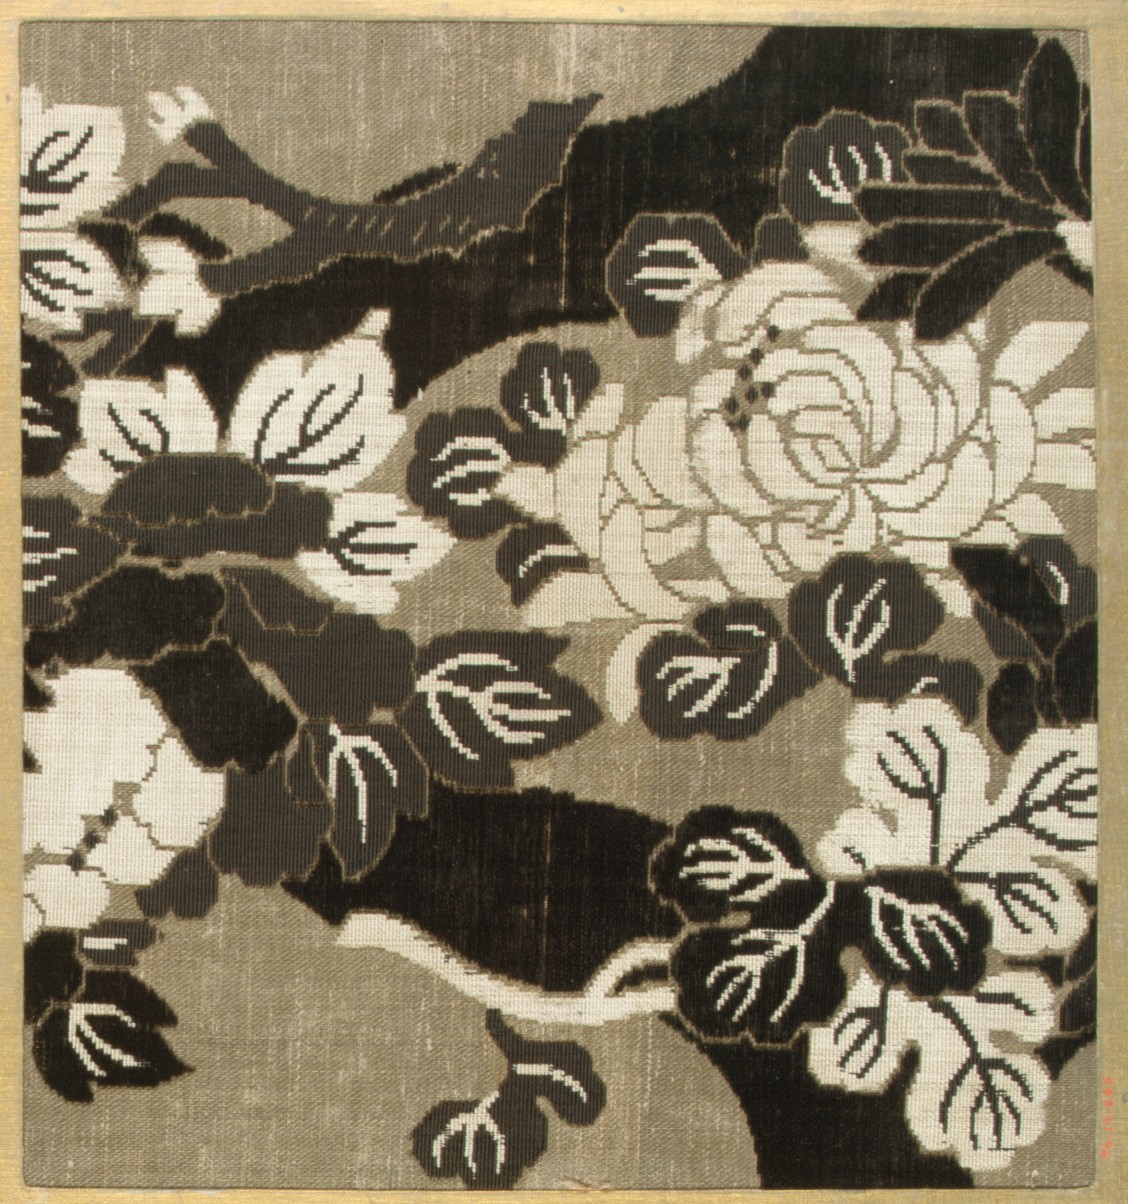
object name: piece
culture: japanese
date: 1701-1900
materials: silk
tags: leaves